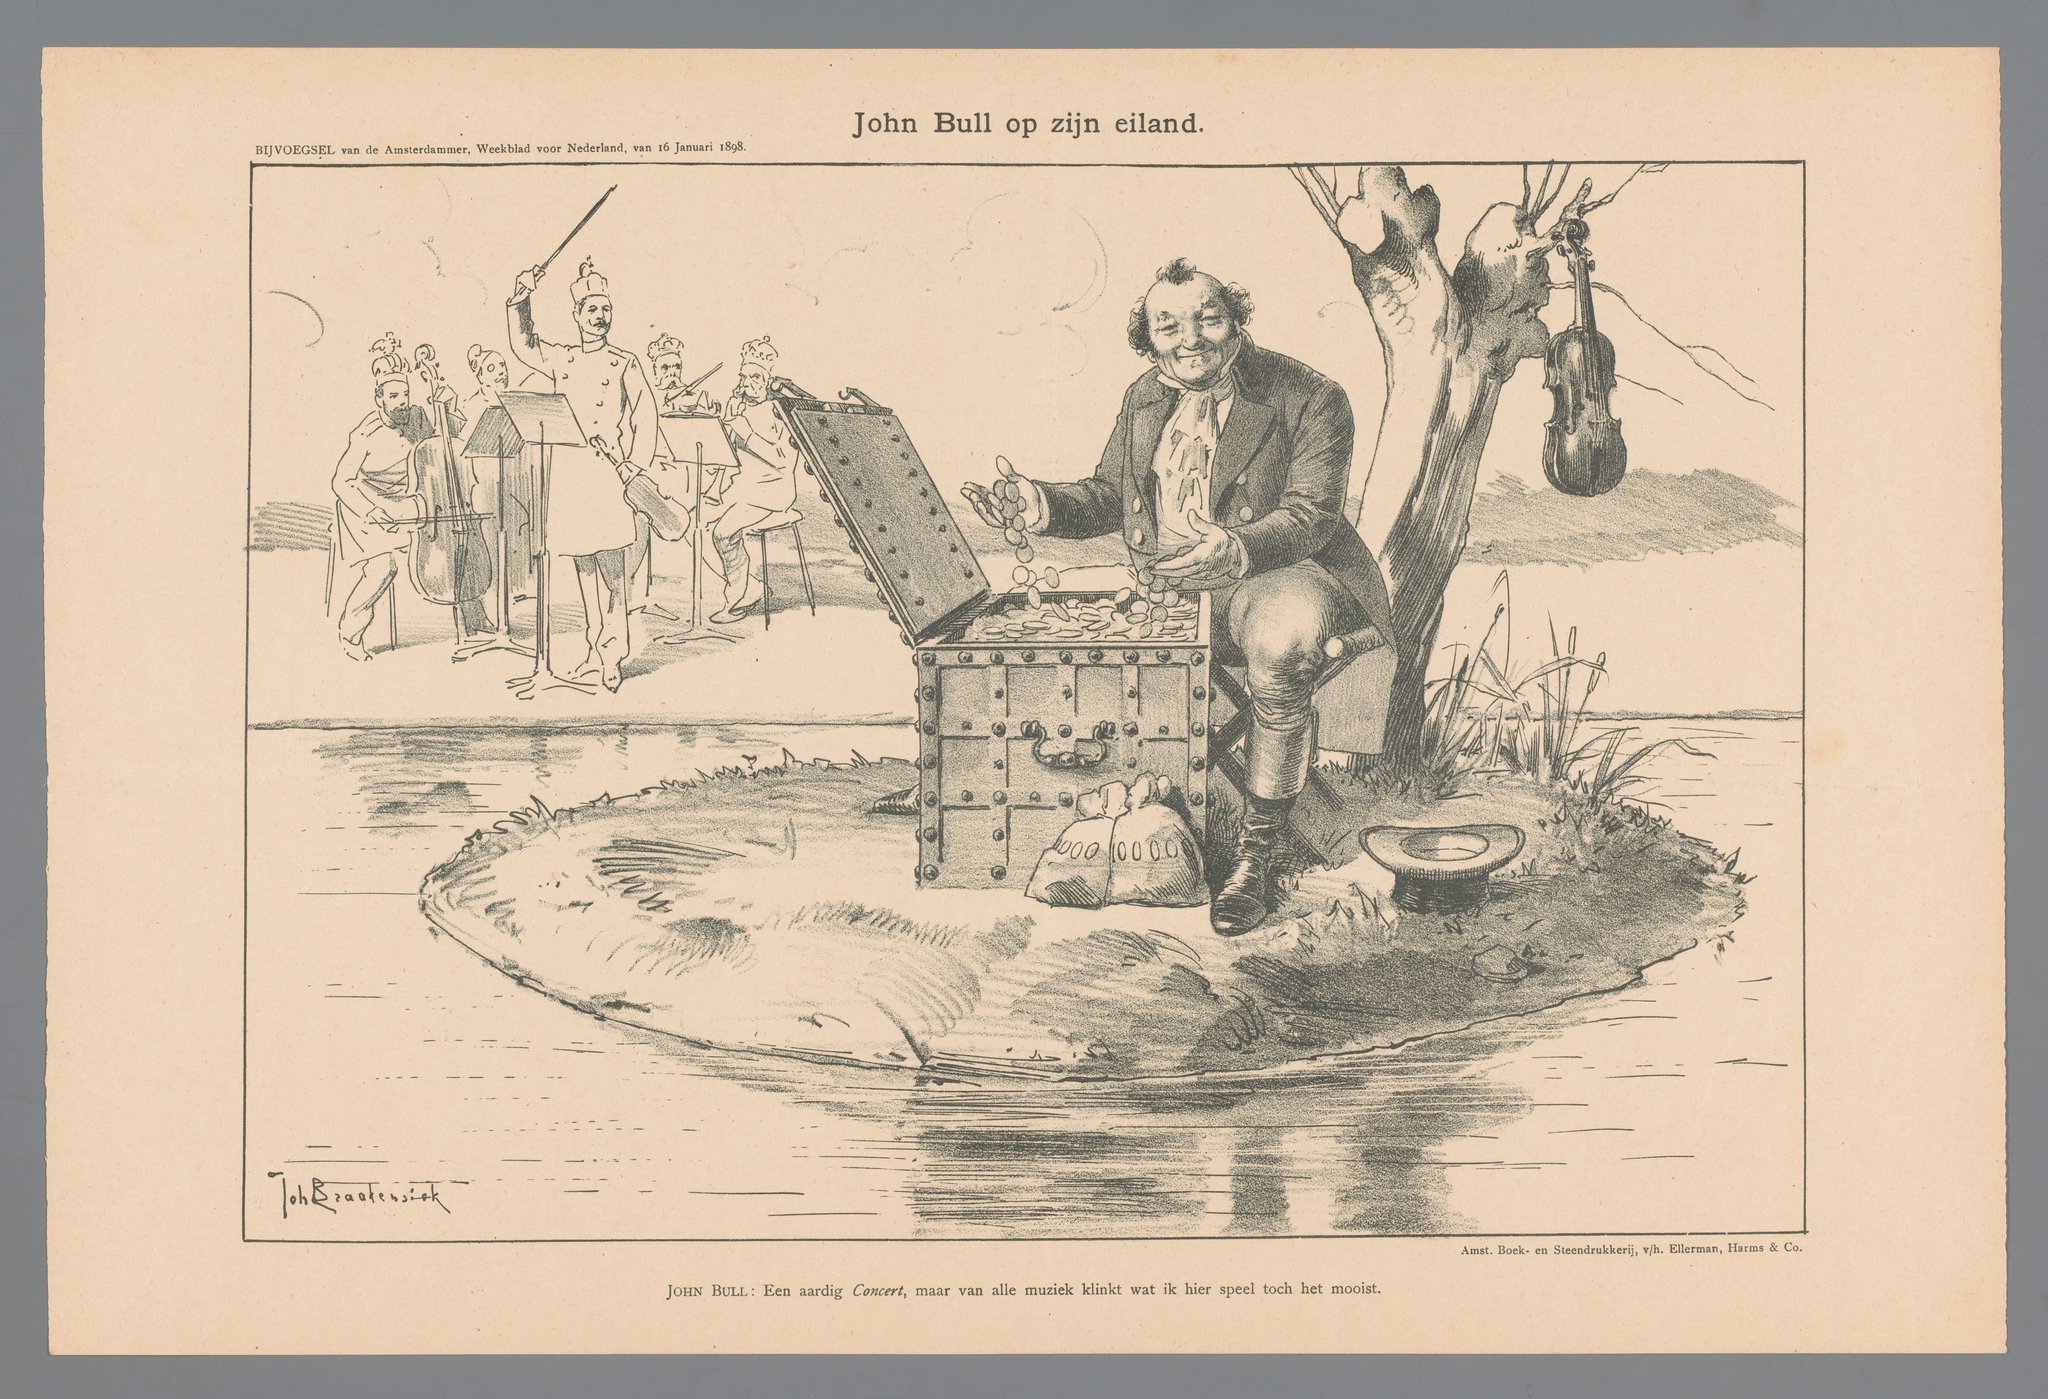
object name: cartoon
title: John Bull op zijn eiland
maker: johan braakensiek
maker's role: draughtsman, print maker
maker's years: 1858-1940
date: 1898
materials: paper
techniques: lithograph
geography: amsterdam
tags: island, more than one musician with instrument - cc - 'concert champêtre', personifications of countries, nations, states, districts, etc. (+ nation; national), money-chest, treasure-chest, money-box, political caricatures and satires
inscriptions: date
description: Prent uit het bijvoegsel van: De Amsterdammer. Weekblad voor Nederland, 16 januari 1898.